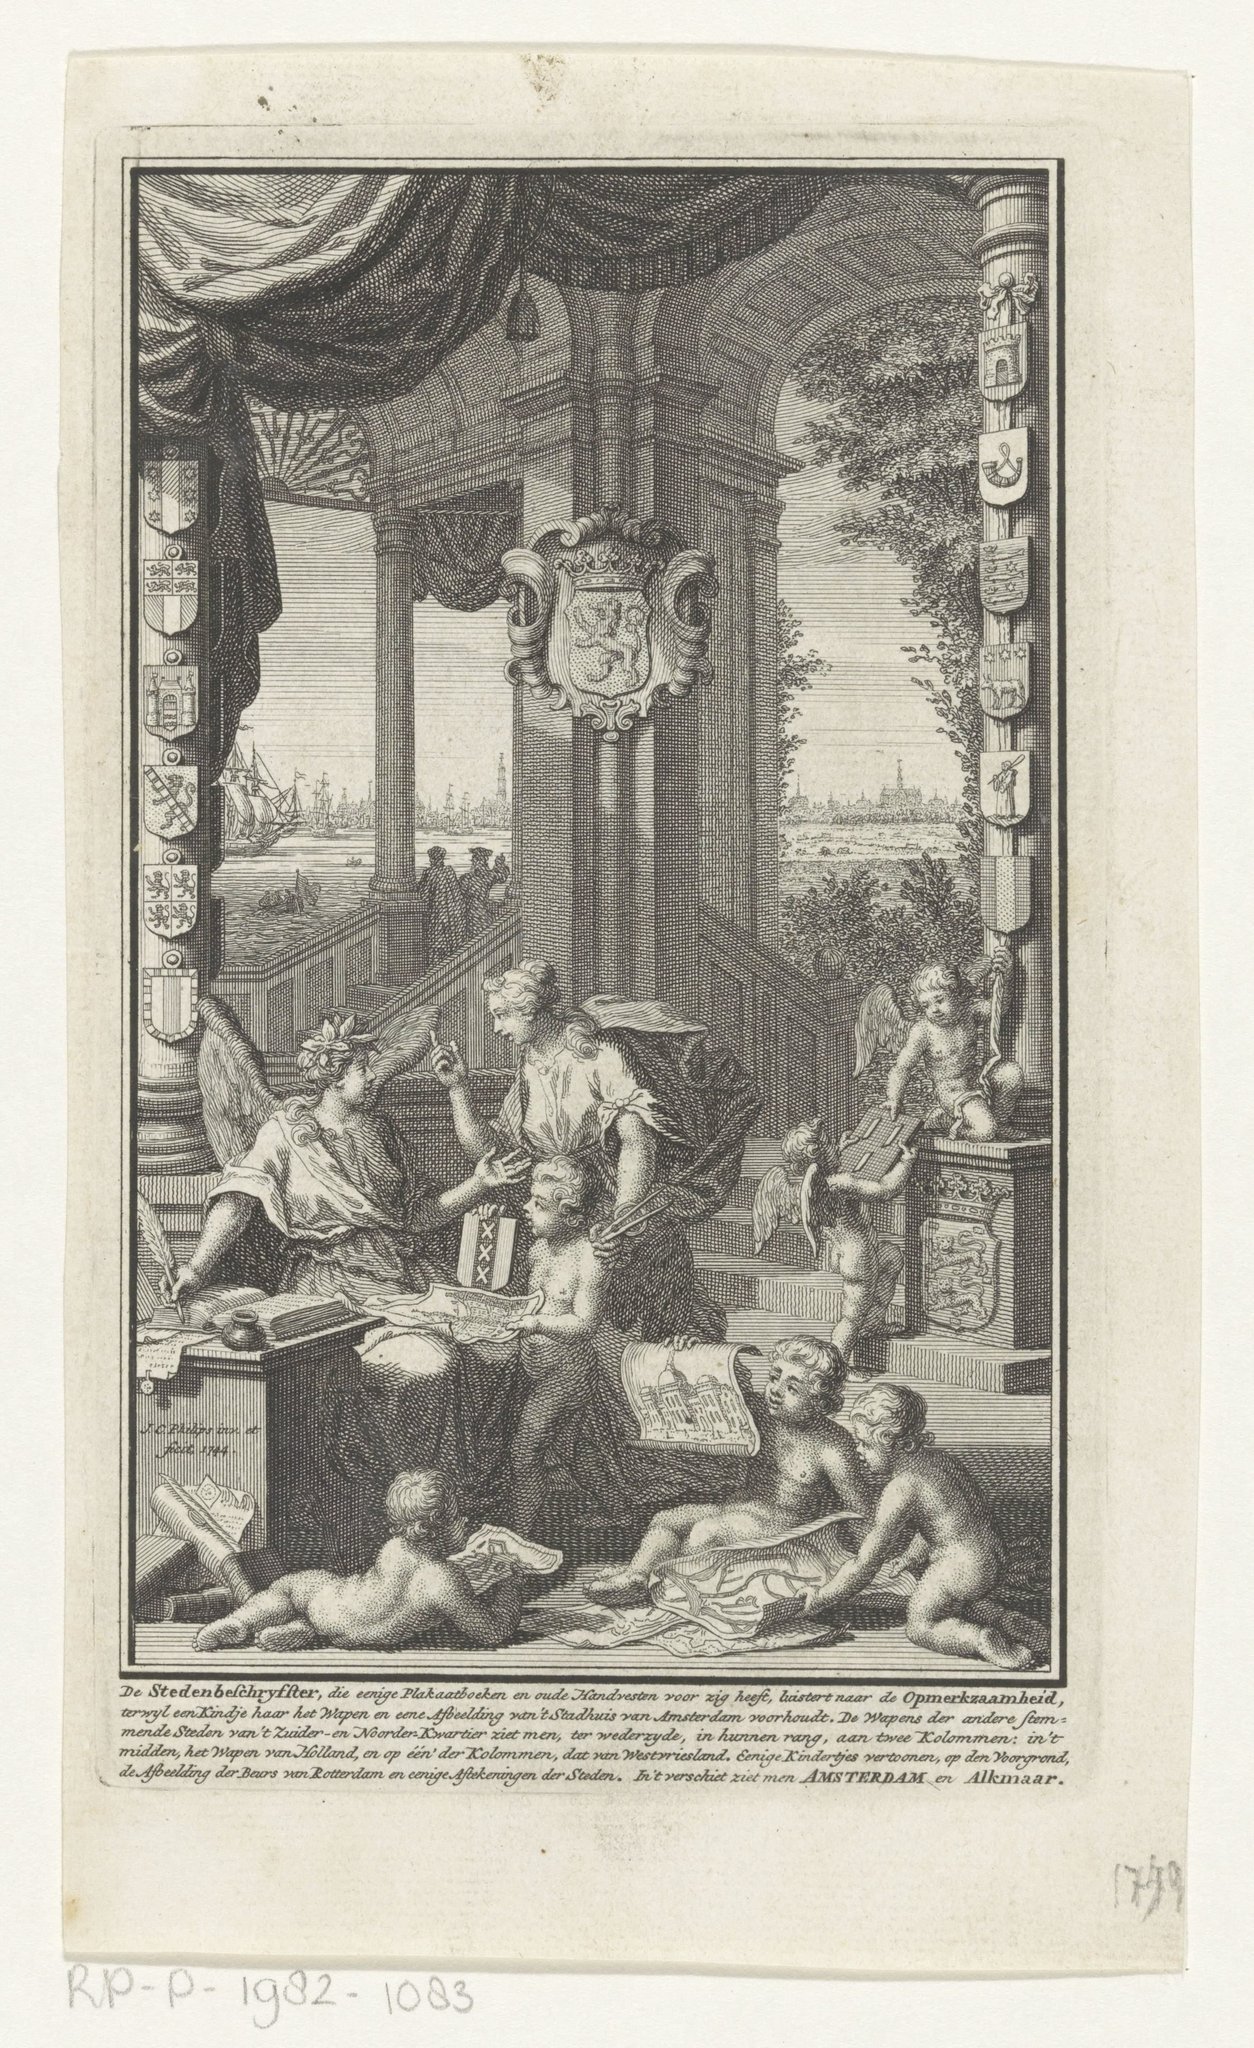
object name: print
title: Allegorie op de provincie Noord-Holland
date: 1744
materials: paper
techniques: engraving, etching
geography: amsterdam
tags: observance, fulfilment, 'historia'; 'historia' (ripa), coat of arms (as symbol of the state, etc.) (+ province; provincial), amsterdam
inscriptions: collector's mark: Lugt 2228, collector's mark: Lugt 2760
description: Titelpagina voor: Salmon, Thomas en Wagenaar, Jan. Tegenwoordige staat der Vereenigde Nederlanden, Vijfde deel. Amsterdam: Tirion, Isaak, 1744. / Titelpagina voor: Salmon, Thomas. Hedendaagsche historie of tegenwoordige staat van alle volkeren, XVde deel. Amsterdam: Tirion, Isaak, 1744. Tussen 1739 en 1804 verscheen bij de Amsterdamse uitgever Isaak Tirion een serie van 23 delen ‘Tegenwoordige staat der Vereenigde Nederlanden’, een verzamelwerk voor een groot deel van de hand van Jan Wagenaar. Deze 23 delen waren een onderdeel van een veel groter werk, de ‘Hedendaagsche historie of tegenwoordige staat van alle volkeren’, waarvan het eerste deel in 1729 was verschenen. Beide series hebben een eigen nummering: de delen 1 t/m 23 van de serie over de Vereenigde Nederlanden zijn genummerd 11 t/m 33 van de Tegenwoordige staat van alle volkeren.